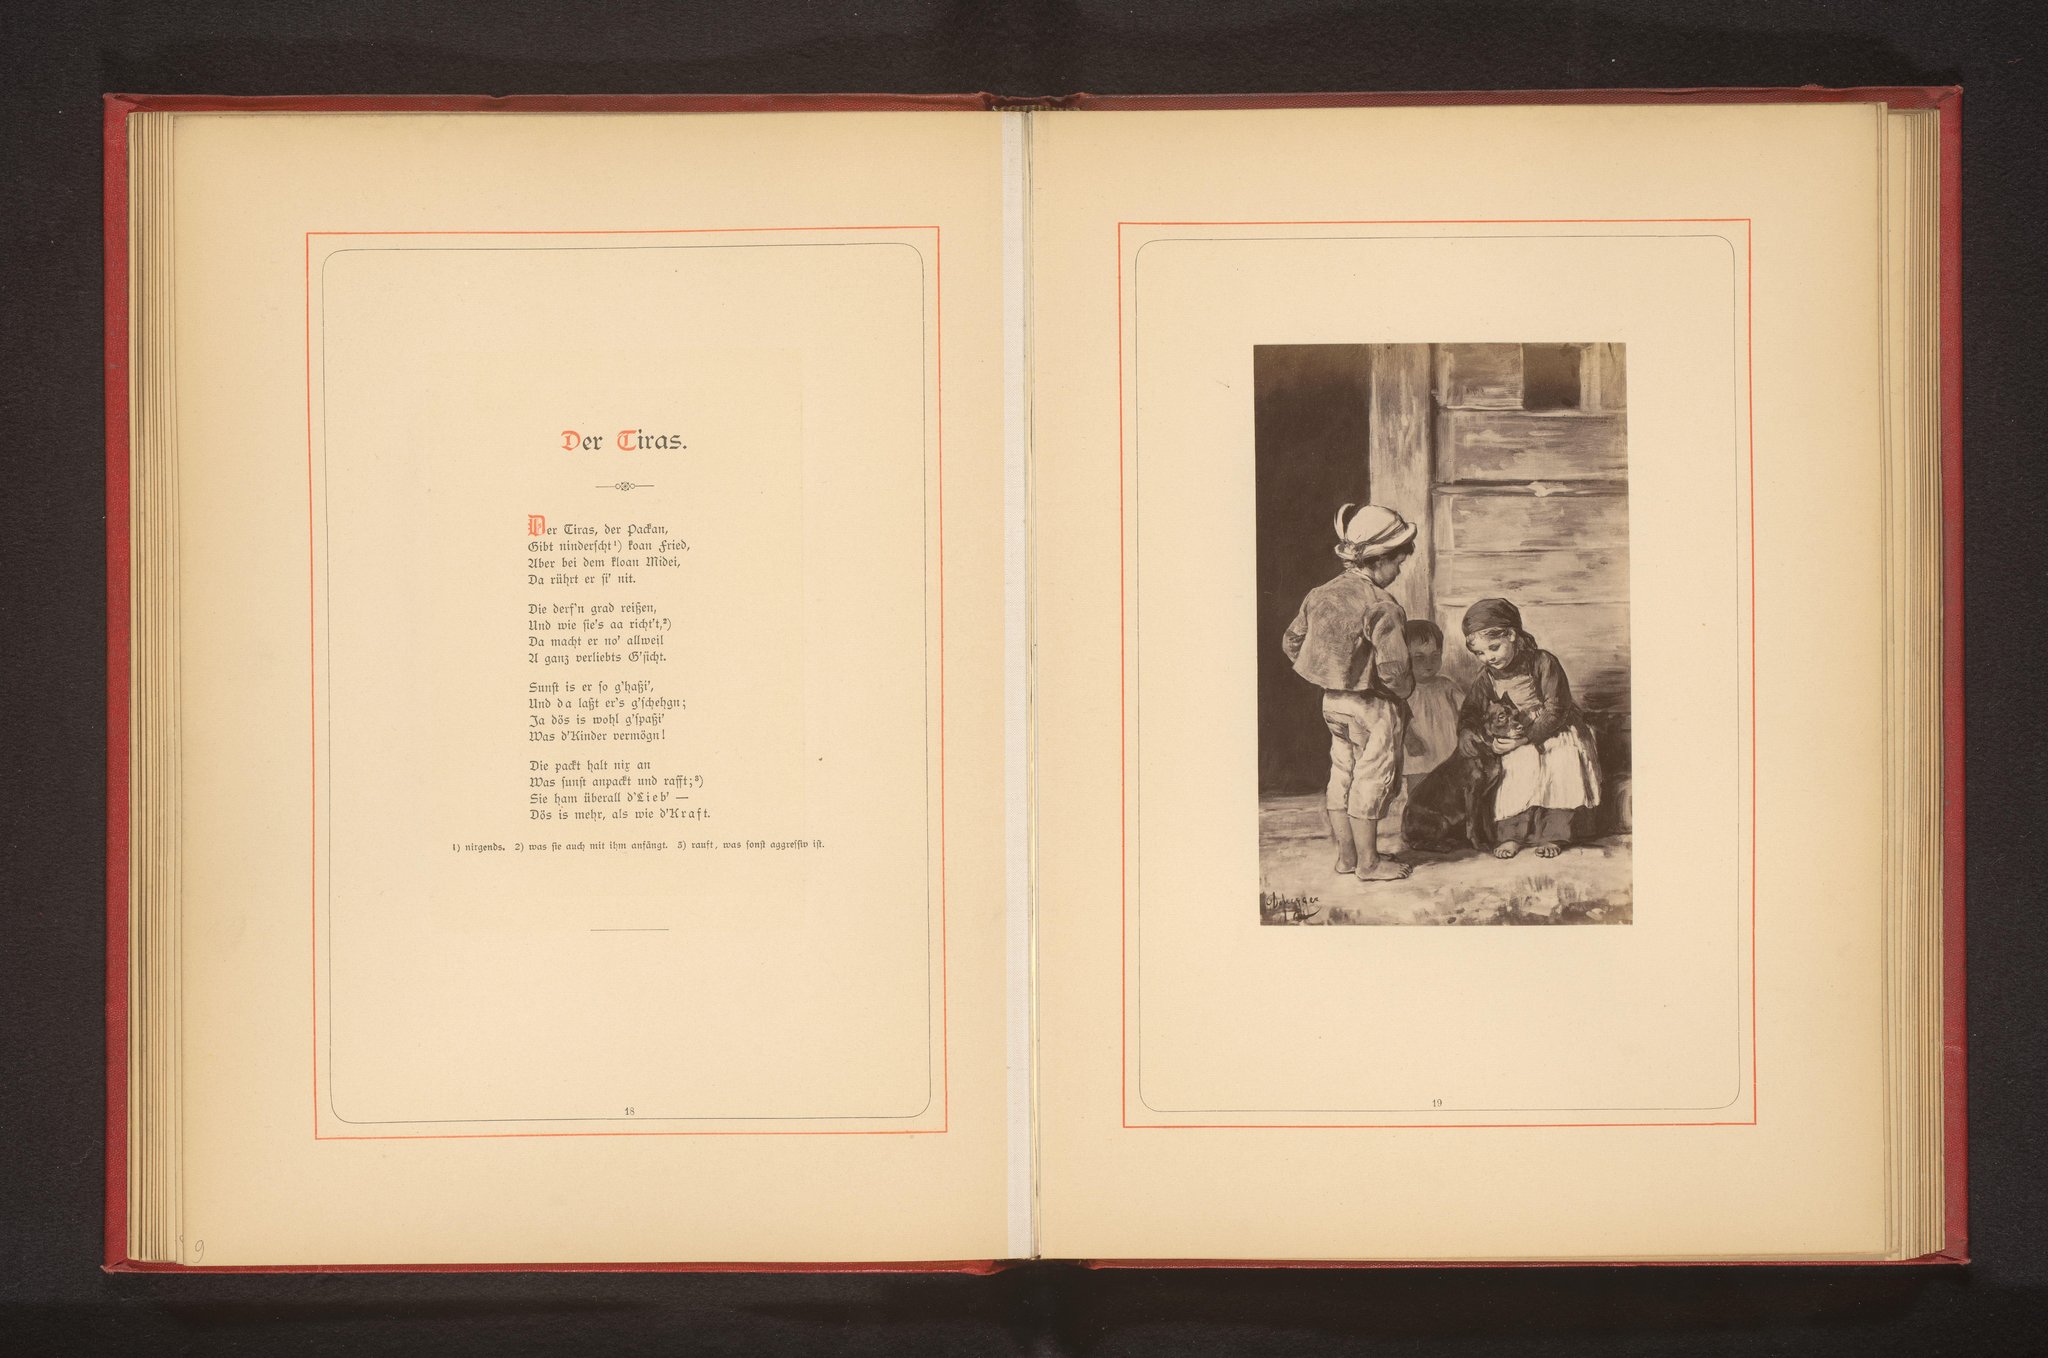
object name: reproduction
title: Fotoreproductie van een schilderij, voorstellende drie kinderen met een hond voor een gebouw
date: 1880-1883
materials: photographic support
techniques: albumen print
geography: germany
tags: child playing with animals, dog